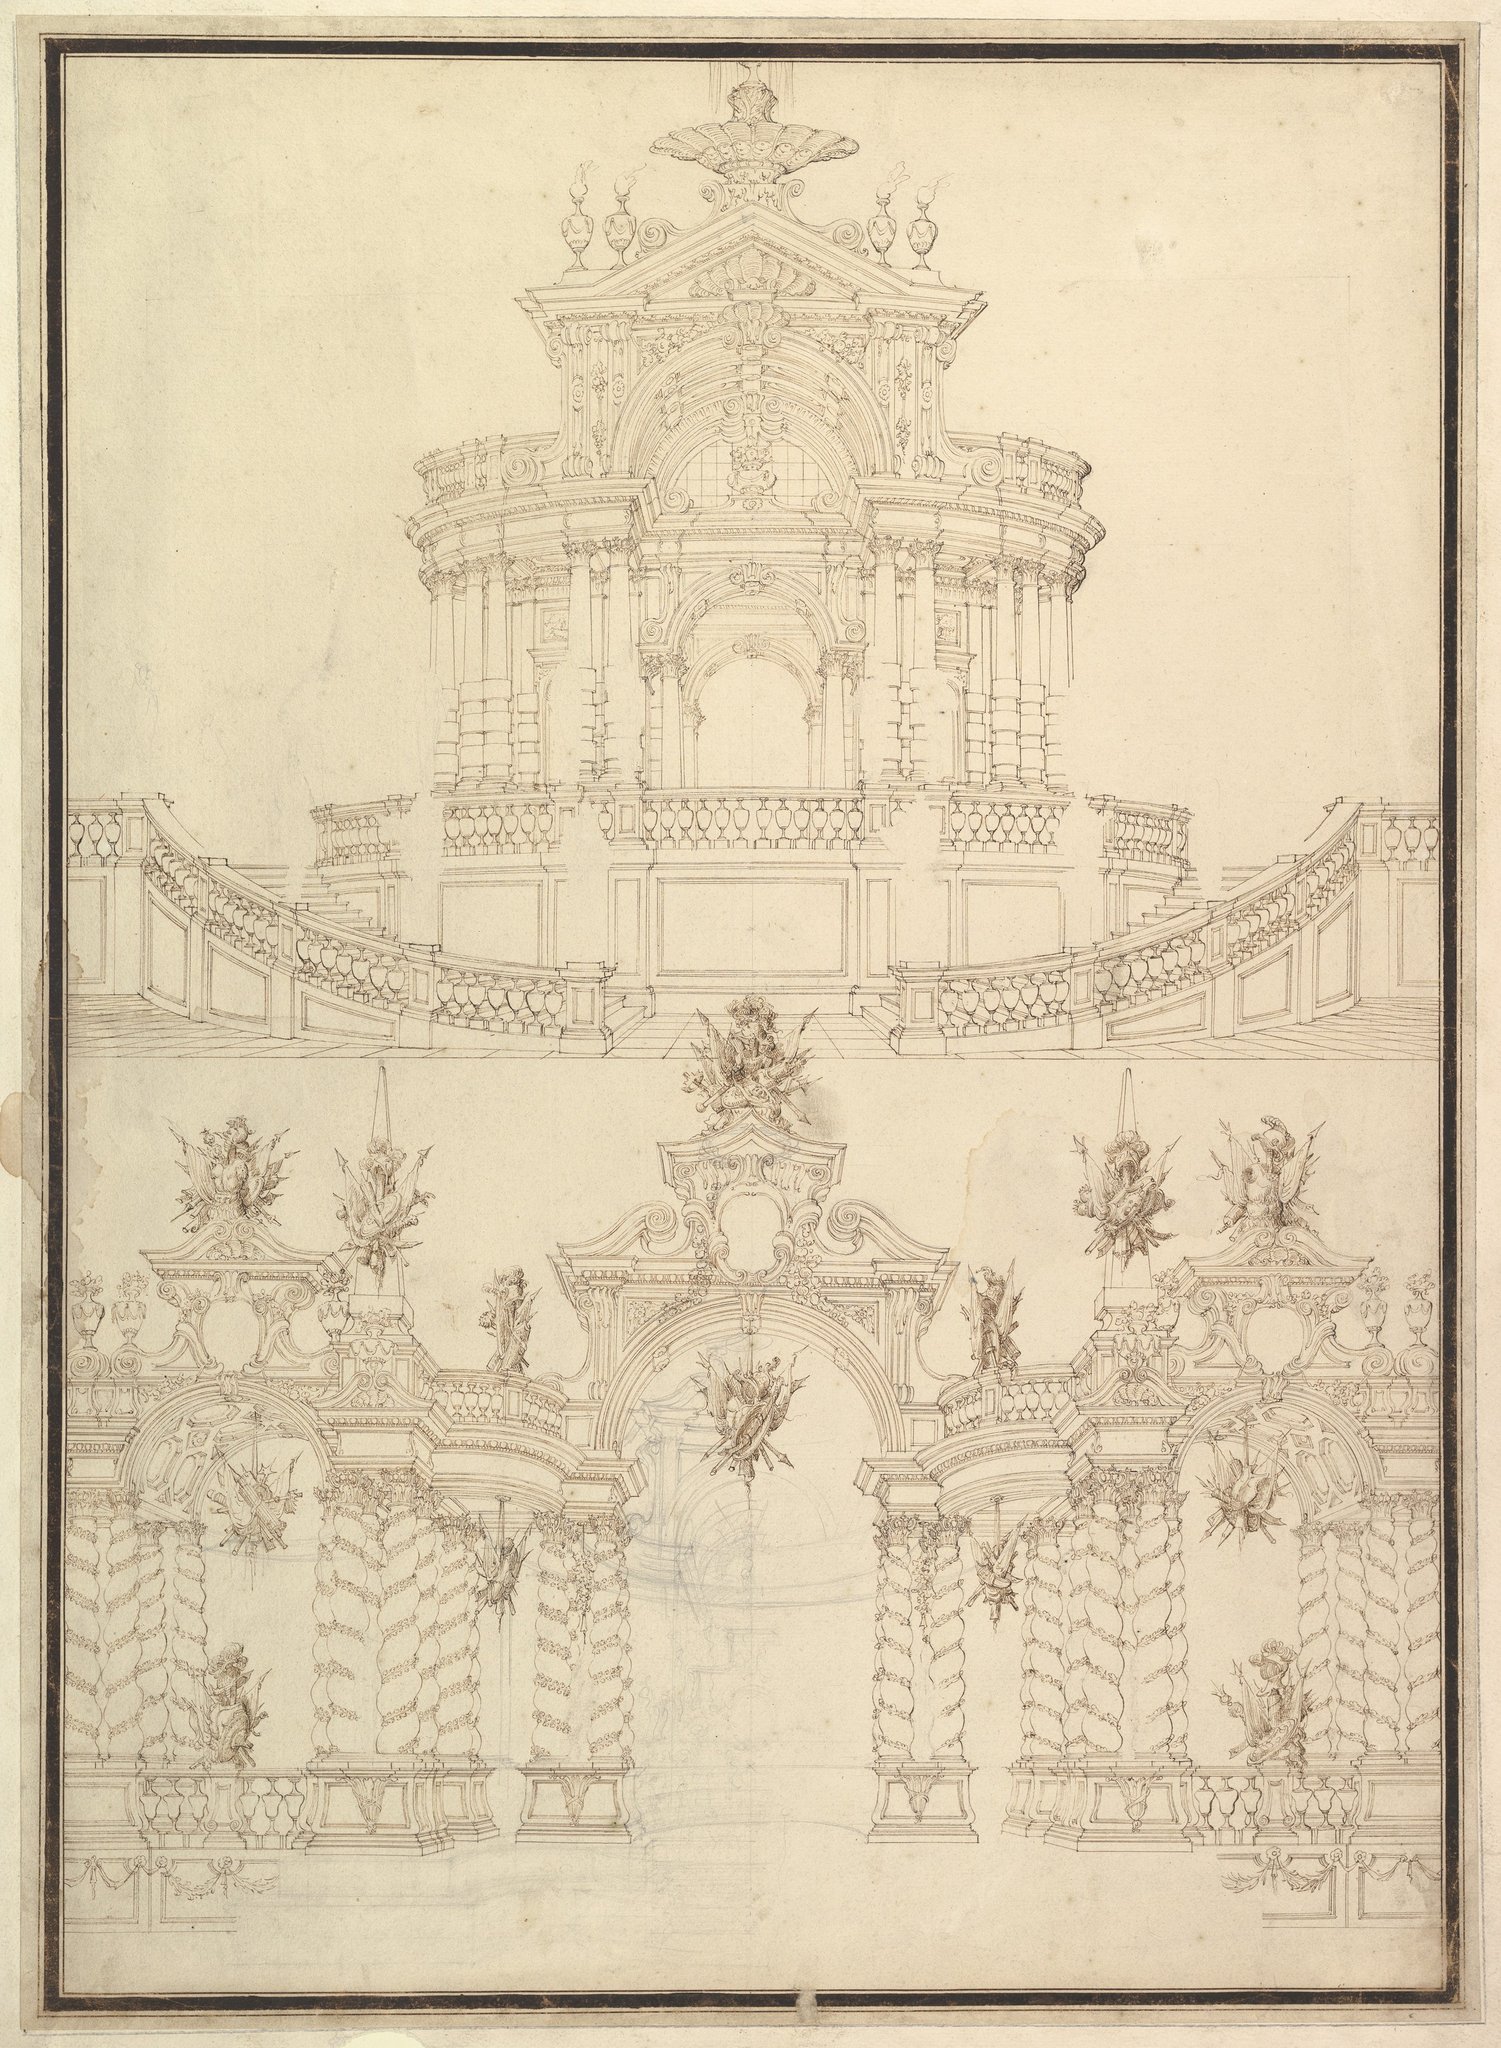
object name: drawing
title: Designs for Components of Stage Sets: at Bottom: Spiral and Wreathed-Colonnaded Pavillion with Central Arch Surmounted by Military Trophy and Another Hanging Inside Arch; at Top: Centralized Pavillion Decorated by Pediment Surmounted by Fountain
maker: giuseppe galli bibiena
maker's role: artist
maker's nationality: italian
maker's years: 1696-1756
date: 1696-1756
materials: chalk, ink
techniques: pen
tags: architecture